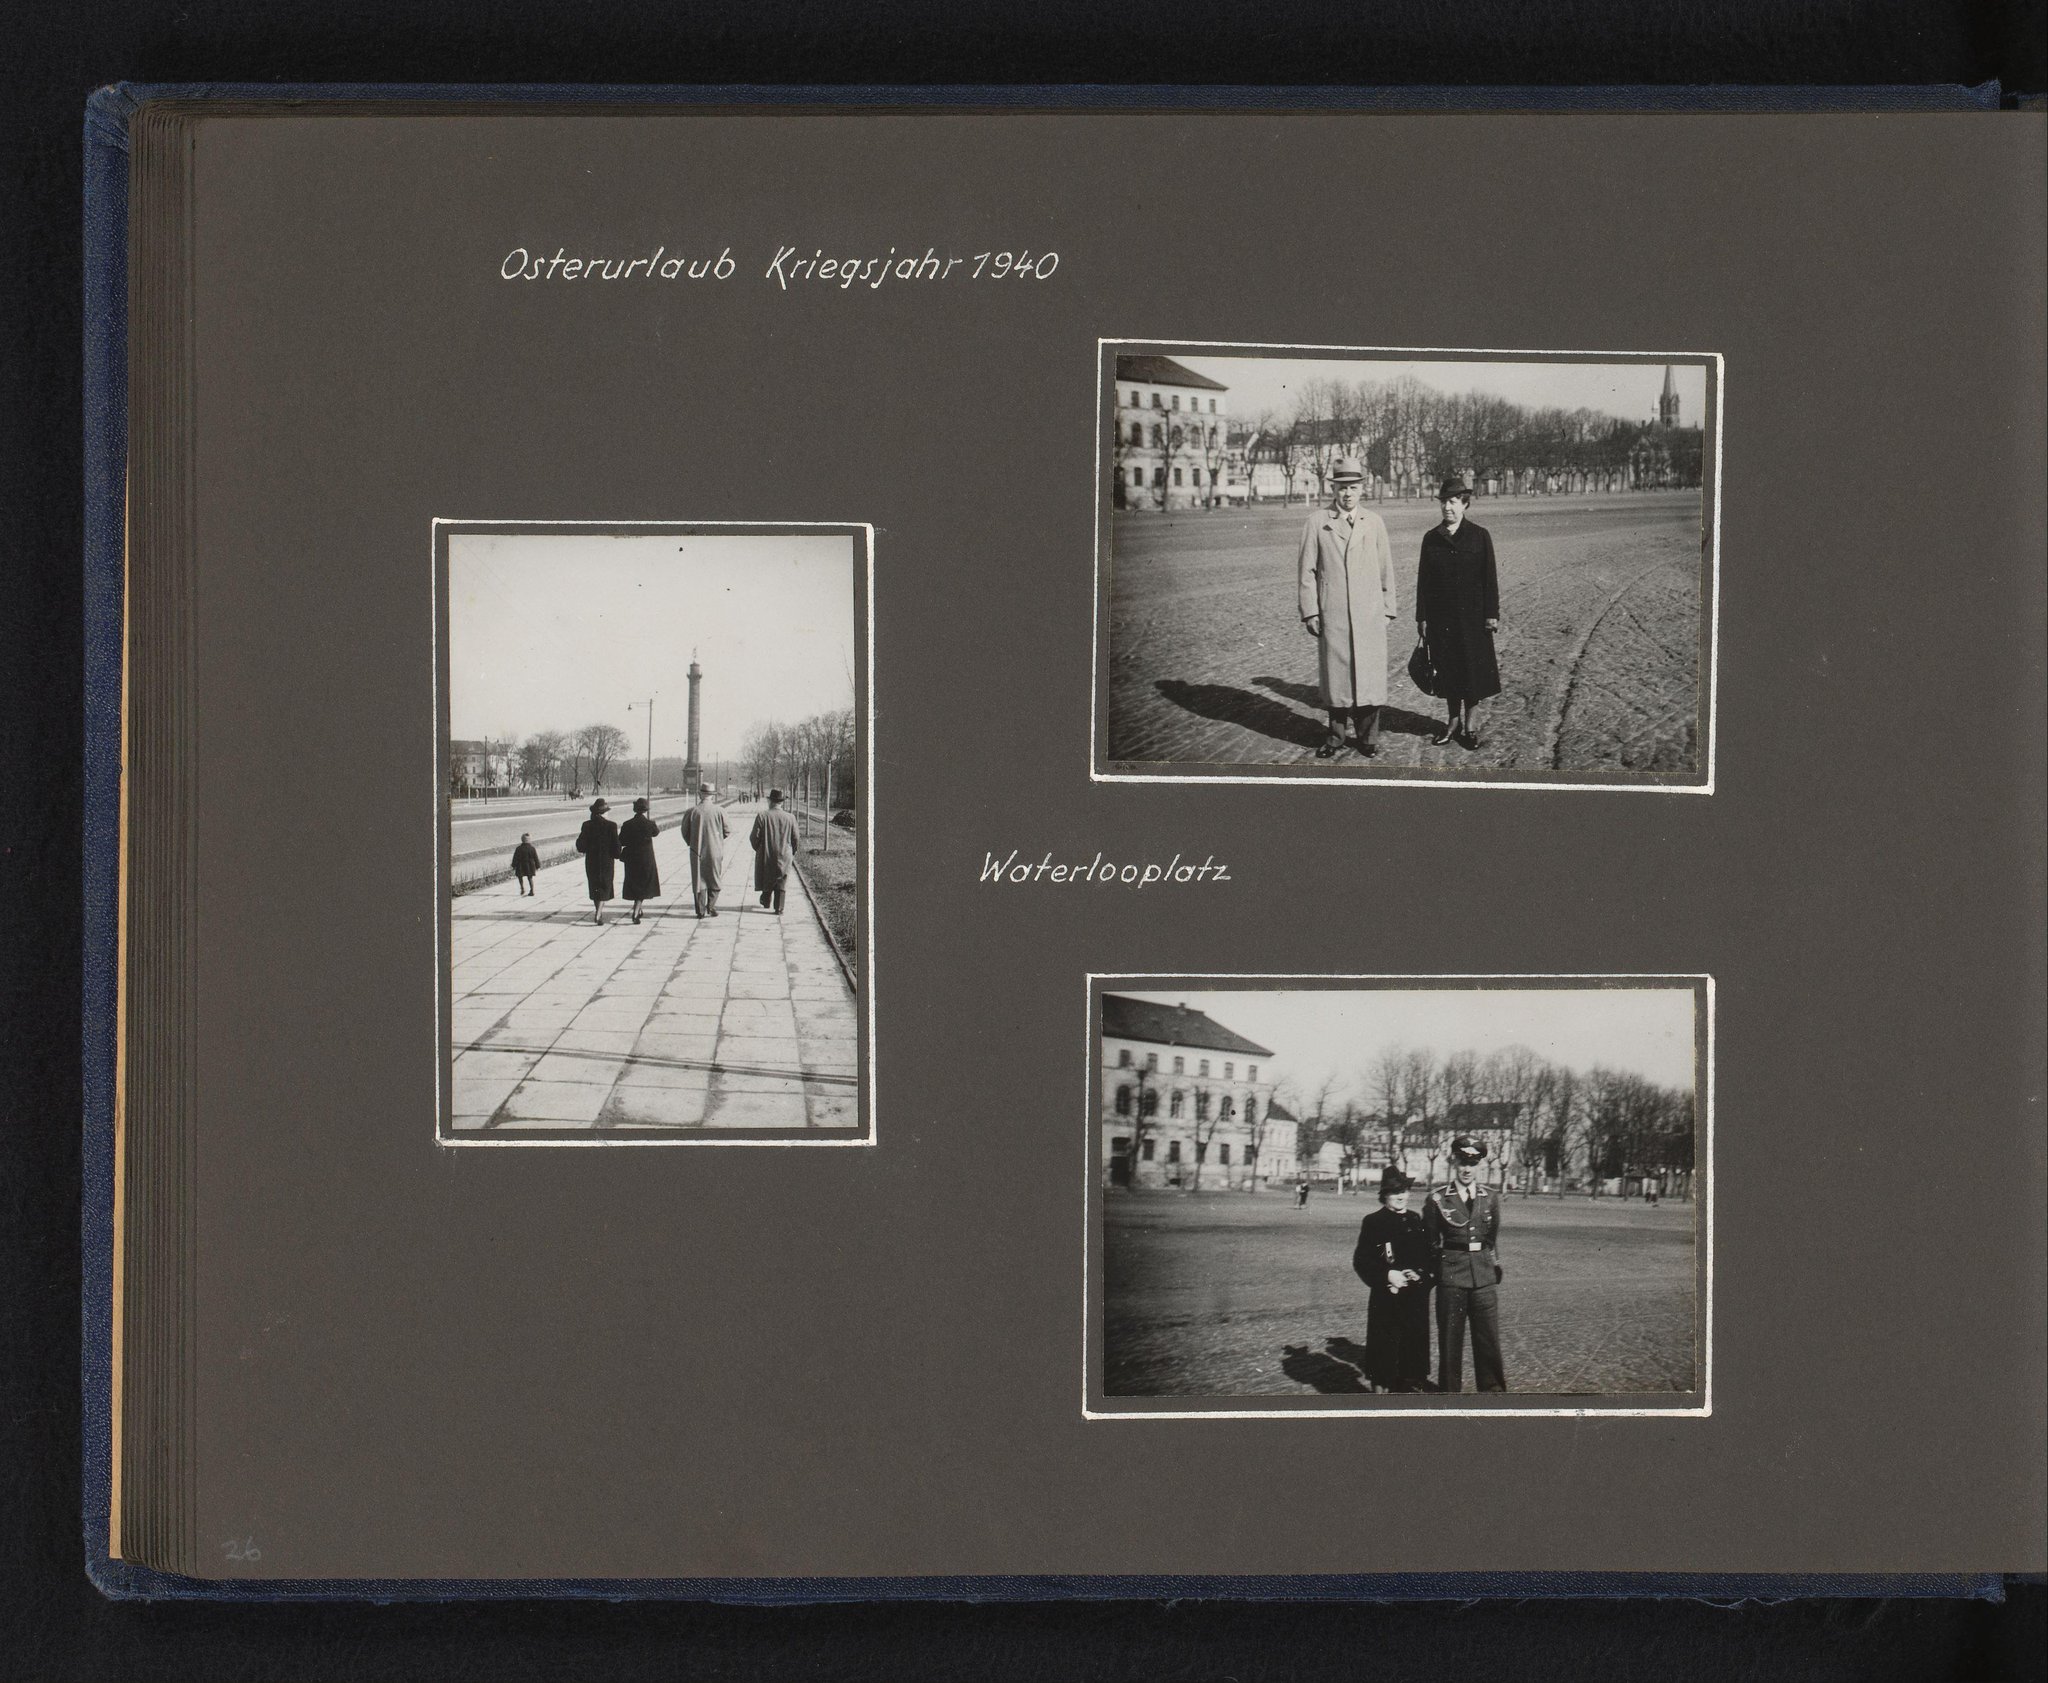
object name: photograph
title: Paasverlof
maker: Anonymous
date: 1940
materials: paper, photographic support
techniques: gelatin silver print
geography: germany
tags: leave ~ the soldier off duty, germany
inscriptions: inscription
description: Albumblad met drie foto's van familiebezoek tijdens verlof met Pasen, 1940. Onderdeel van een Duits militair album Tweede Wereldoorlog 1939-1940.